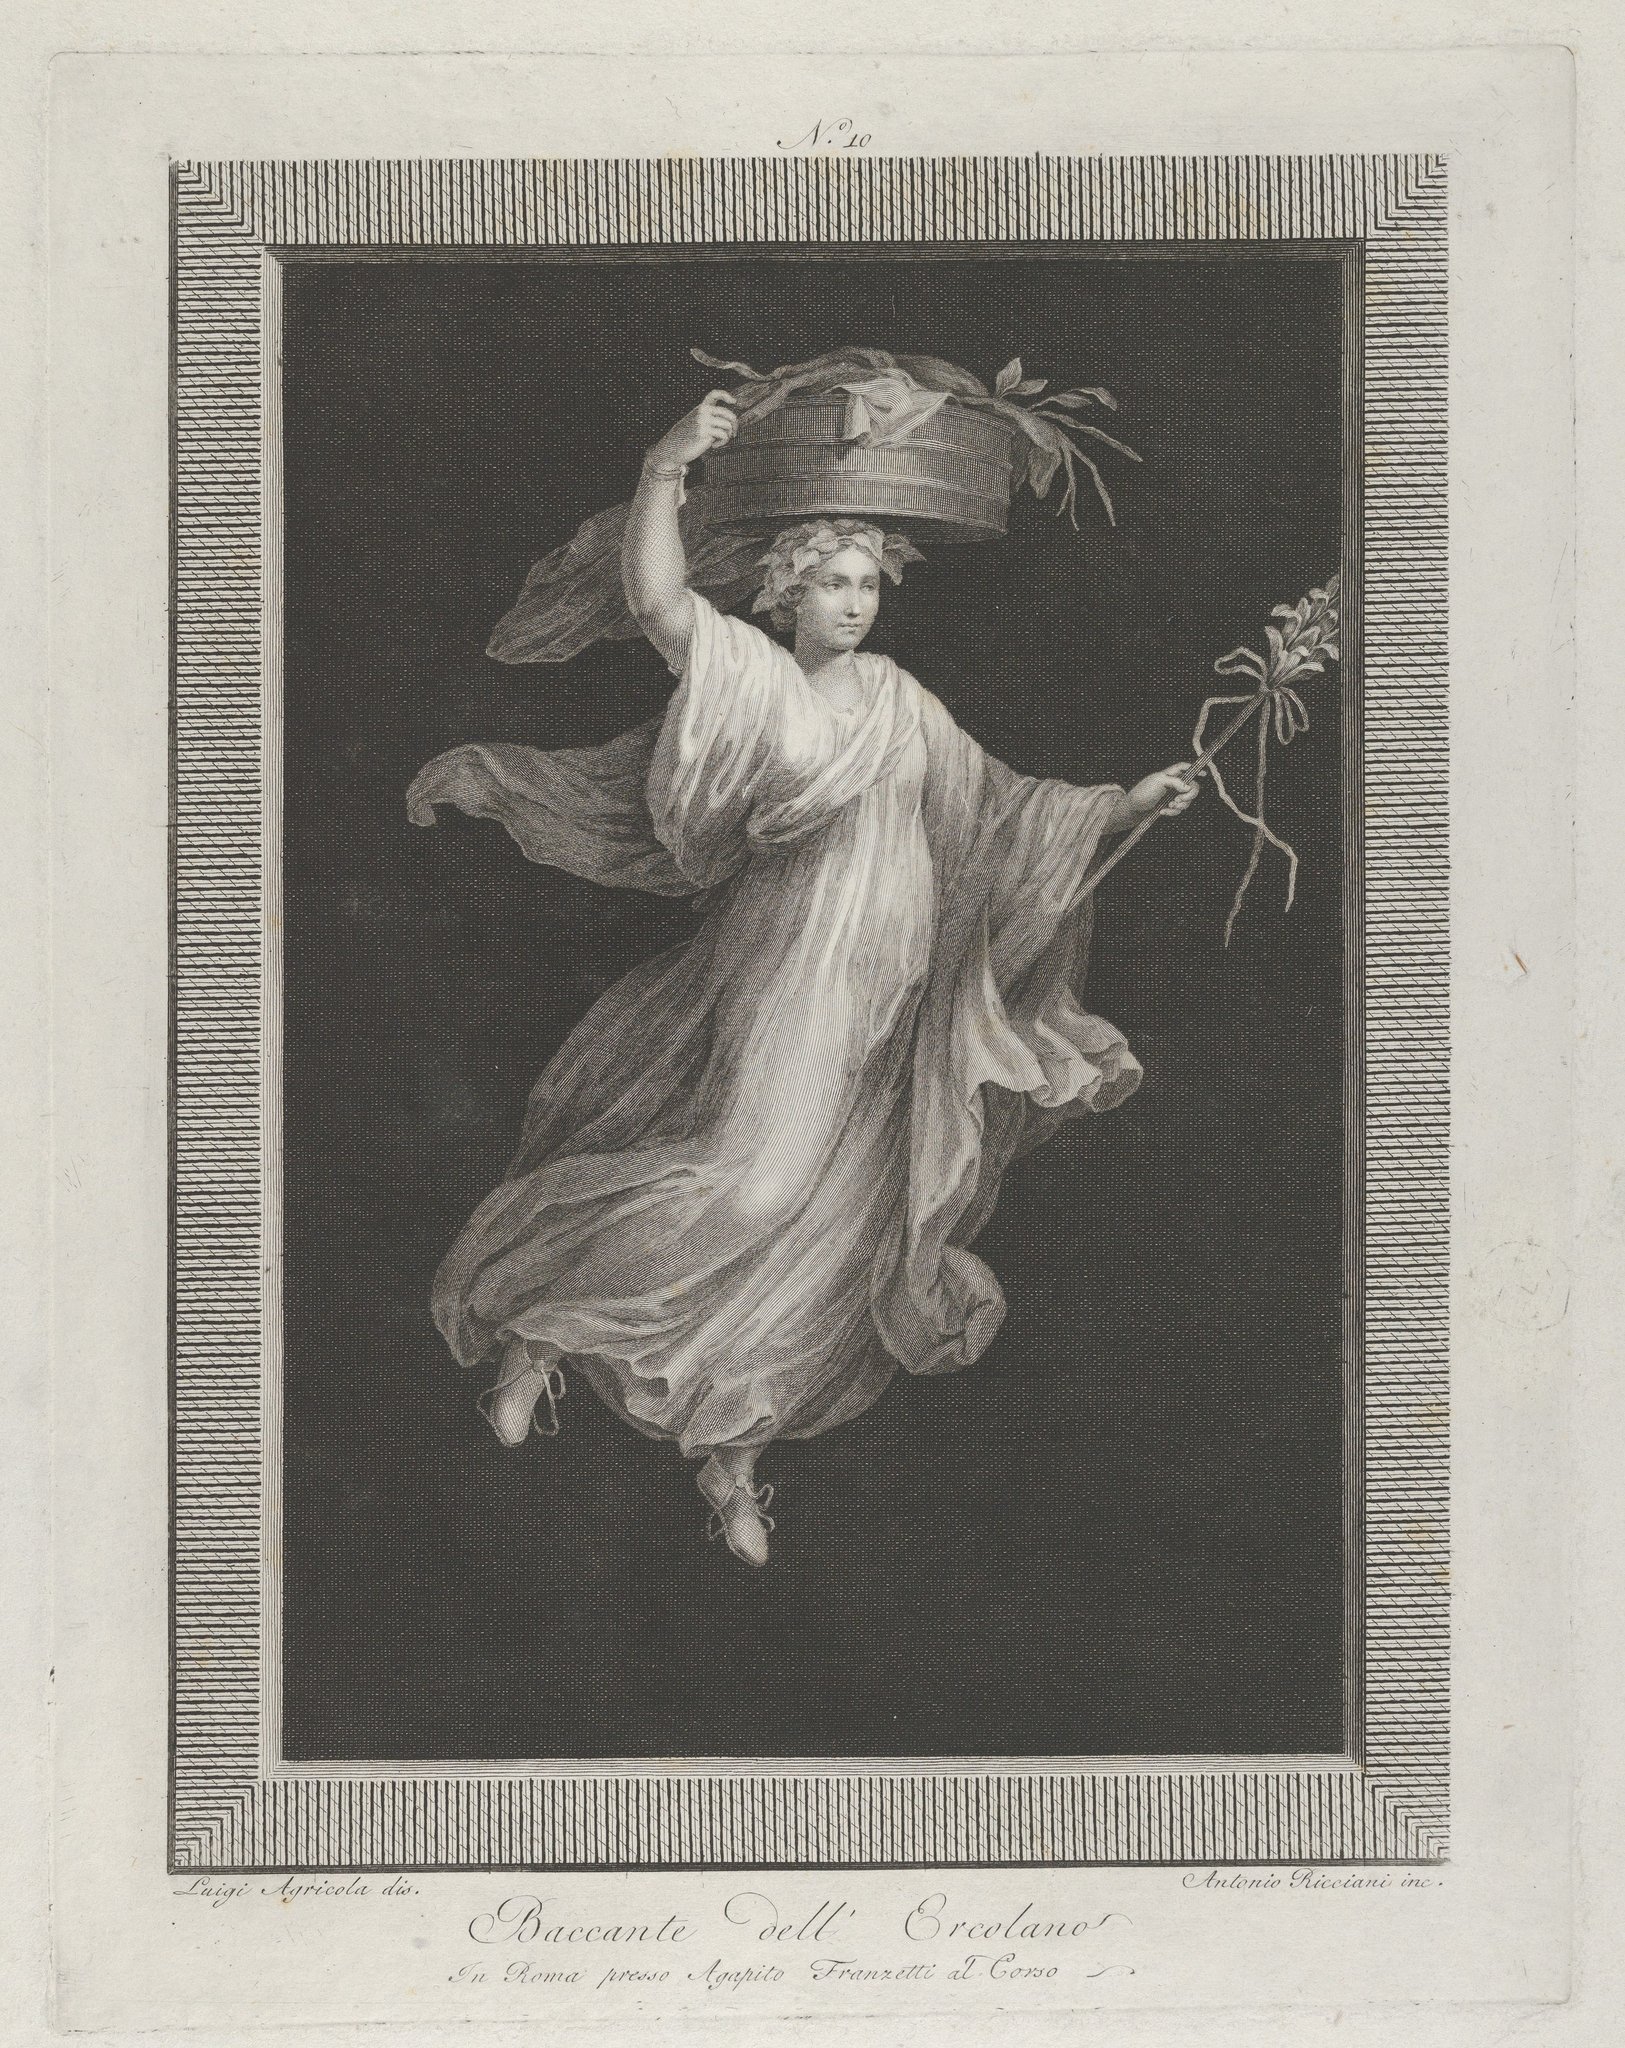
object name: print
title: A bacchante carrying a large basket on her head and holding a staff in her left hand, set against a black background inside a rectangular frame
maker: antonio ricciani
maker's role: artist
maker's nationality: italian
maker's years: 1775-1847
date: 1795-1820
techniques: engraving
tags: bacchantes